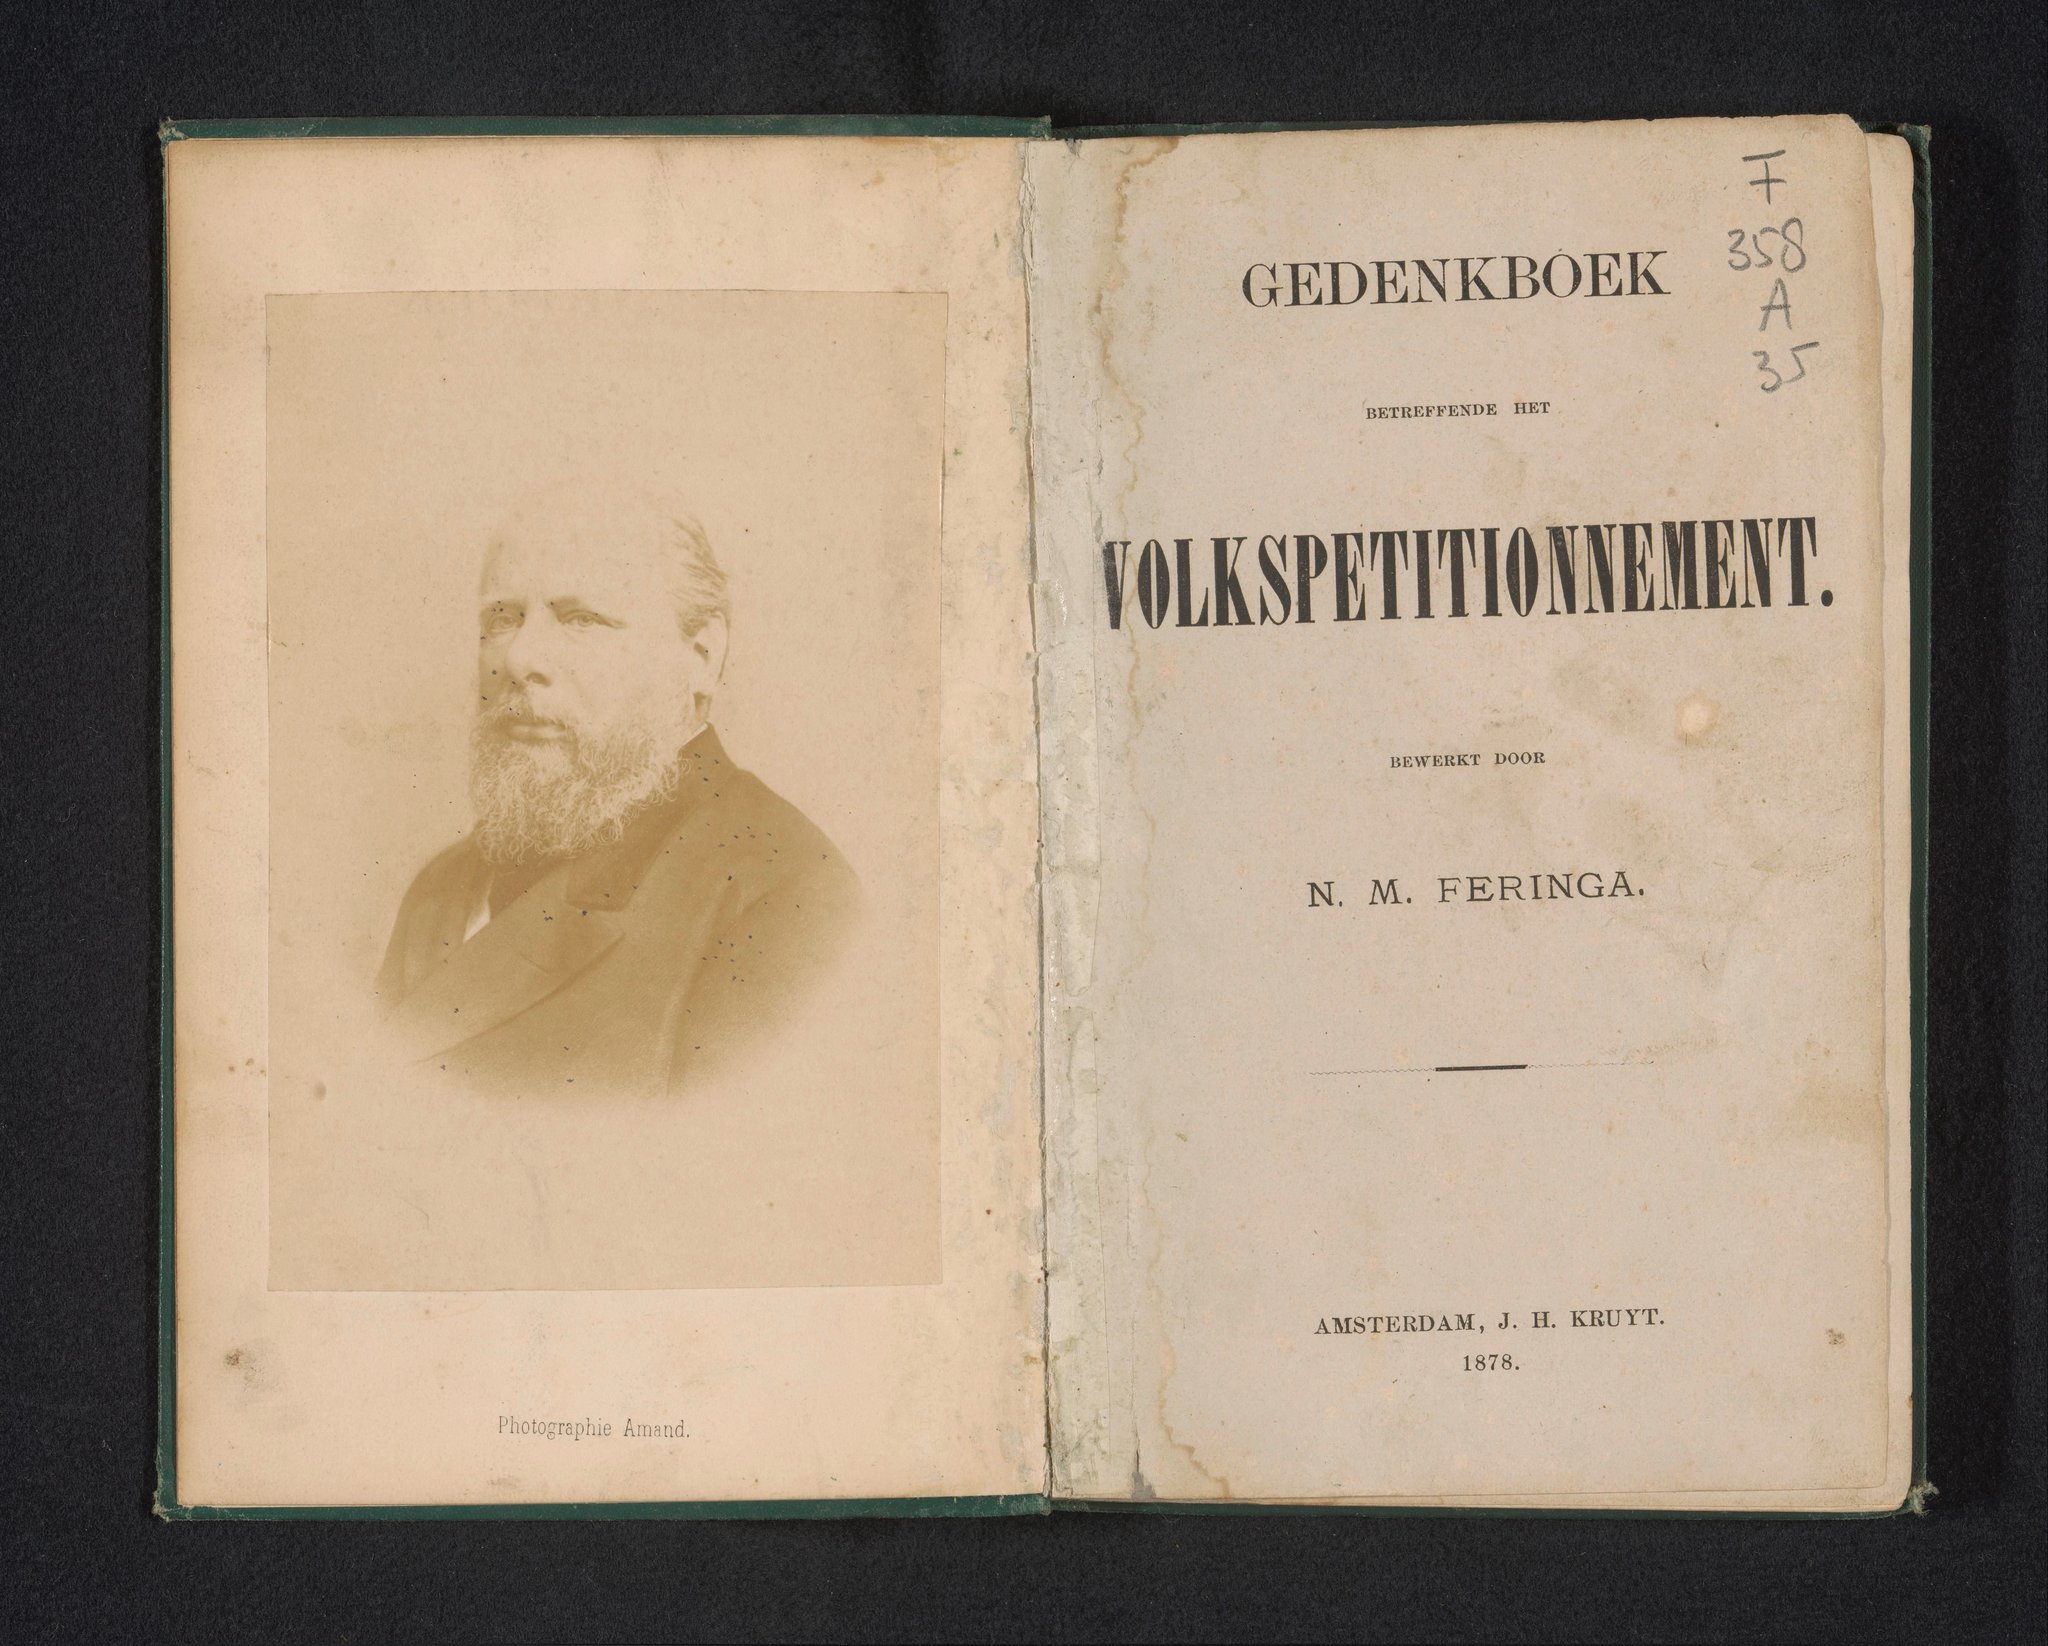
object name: page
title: Portret van koning Willem III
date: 1873-1878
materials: photographic support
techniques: albumen print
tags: brussels, willem iii (koning der nederlanden), historical persons, king